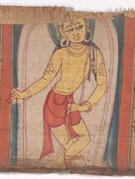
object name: folio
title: Folio from a Manuscript of the Ashtasahasrika Prajnaparamita (Perfection of Wisdom)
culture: indian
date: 1101-1200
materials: ink, leaf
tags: buddhism,deities